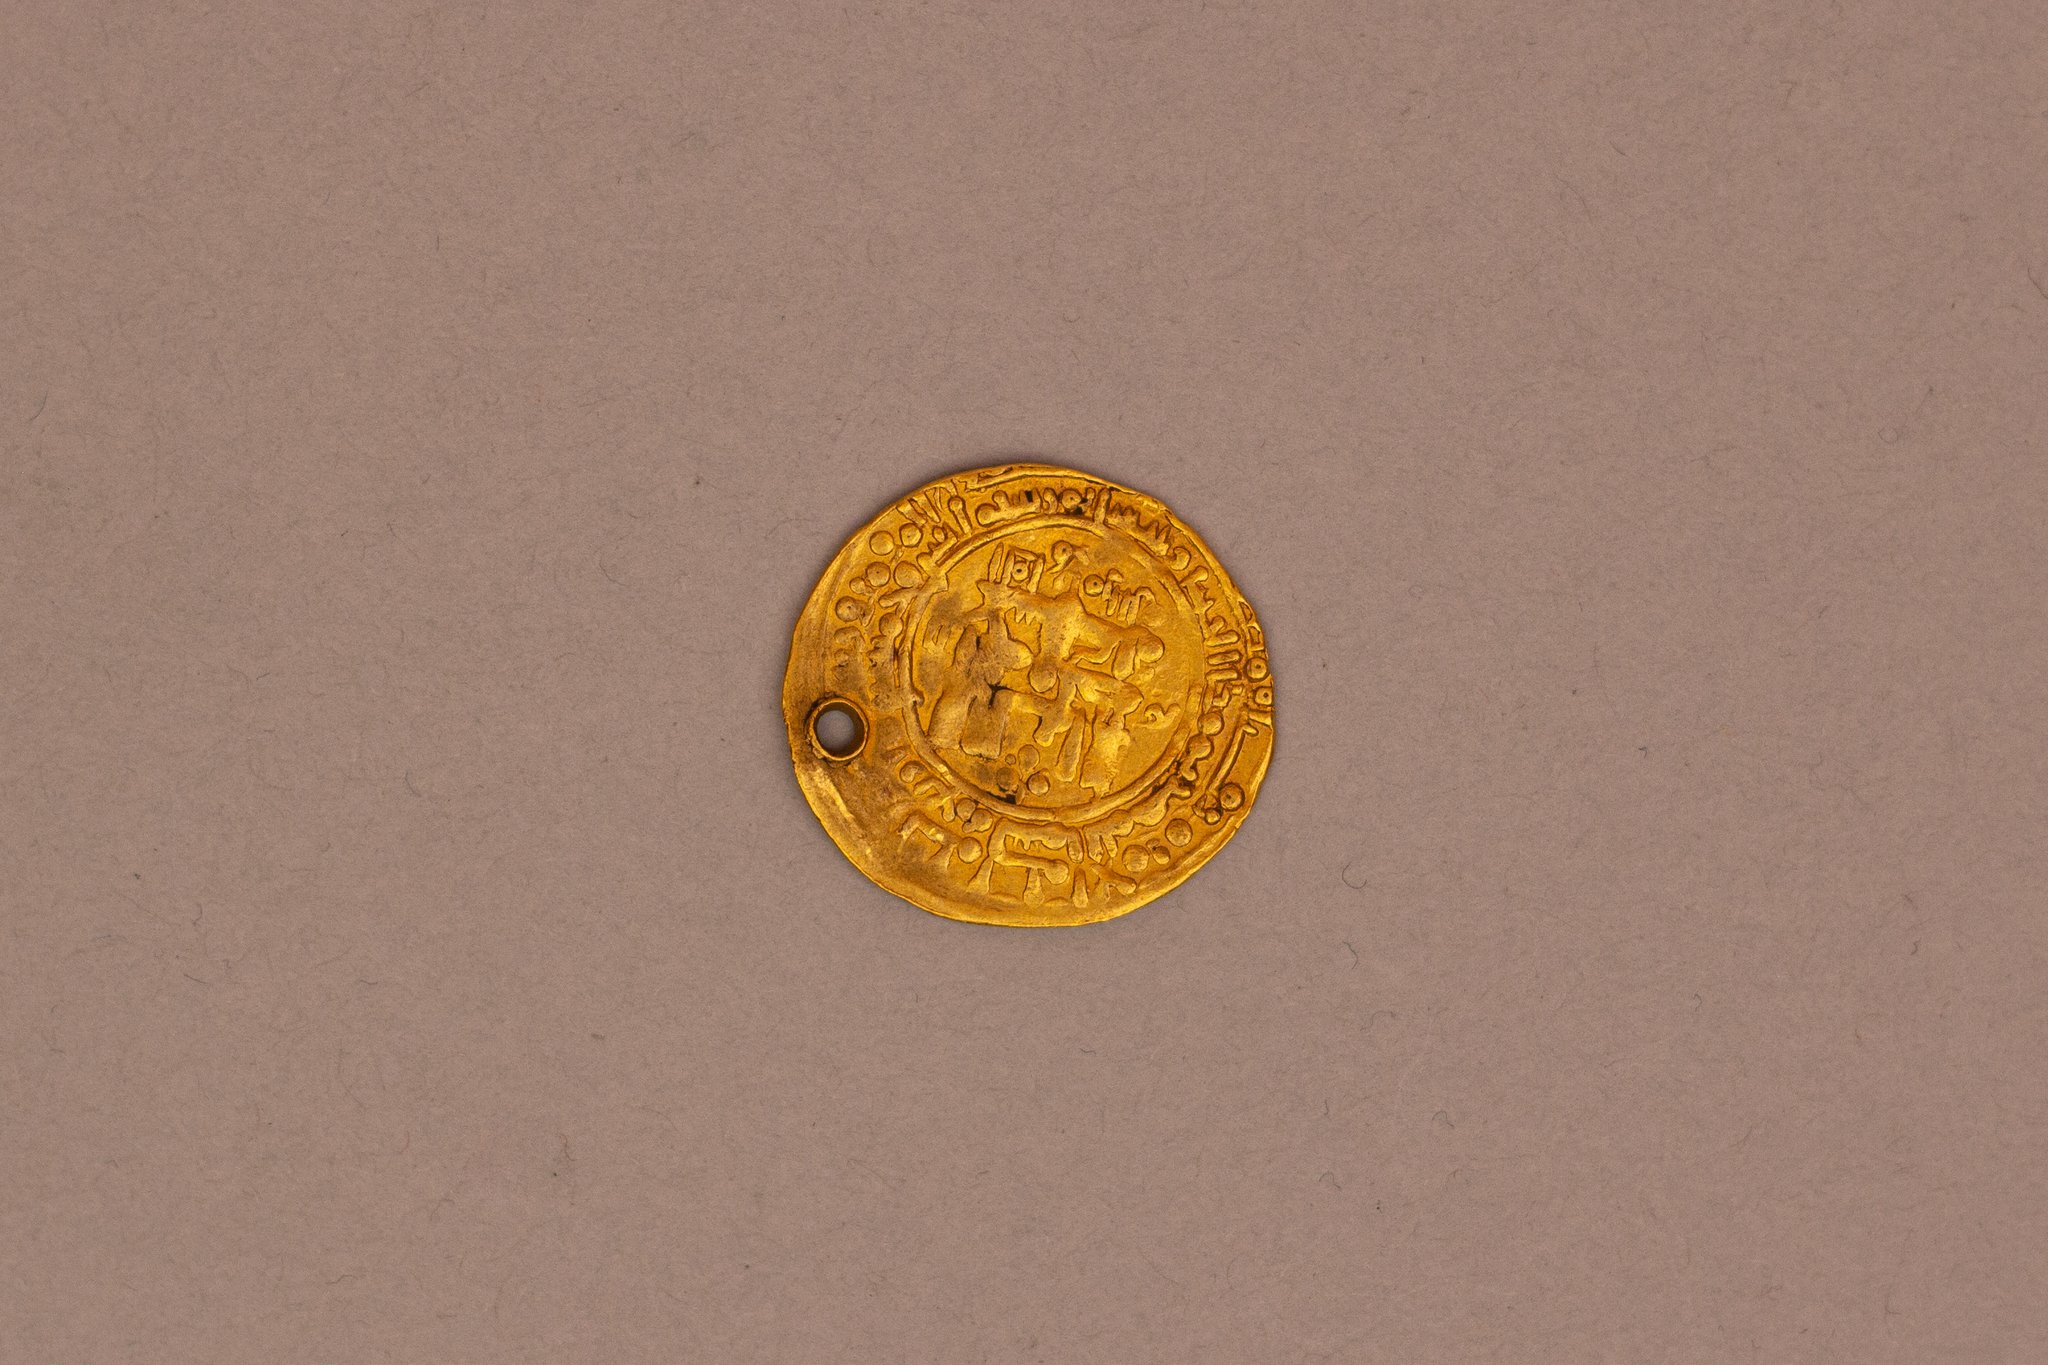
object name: coin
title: Dinar minted in Nishapur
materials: gold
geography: iran